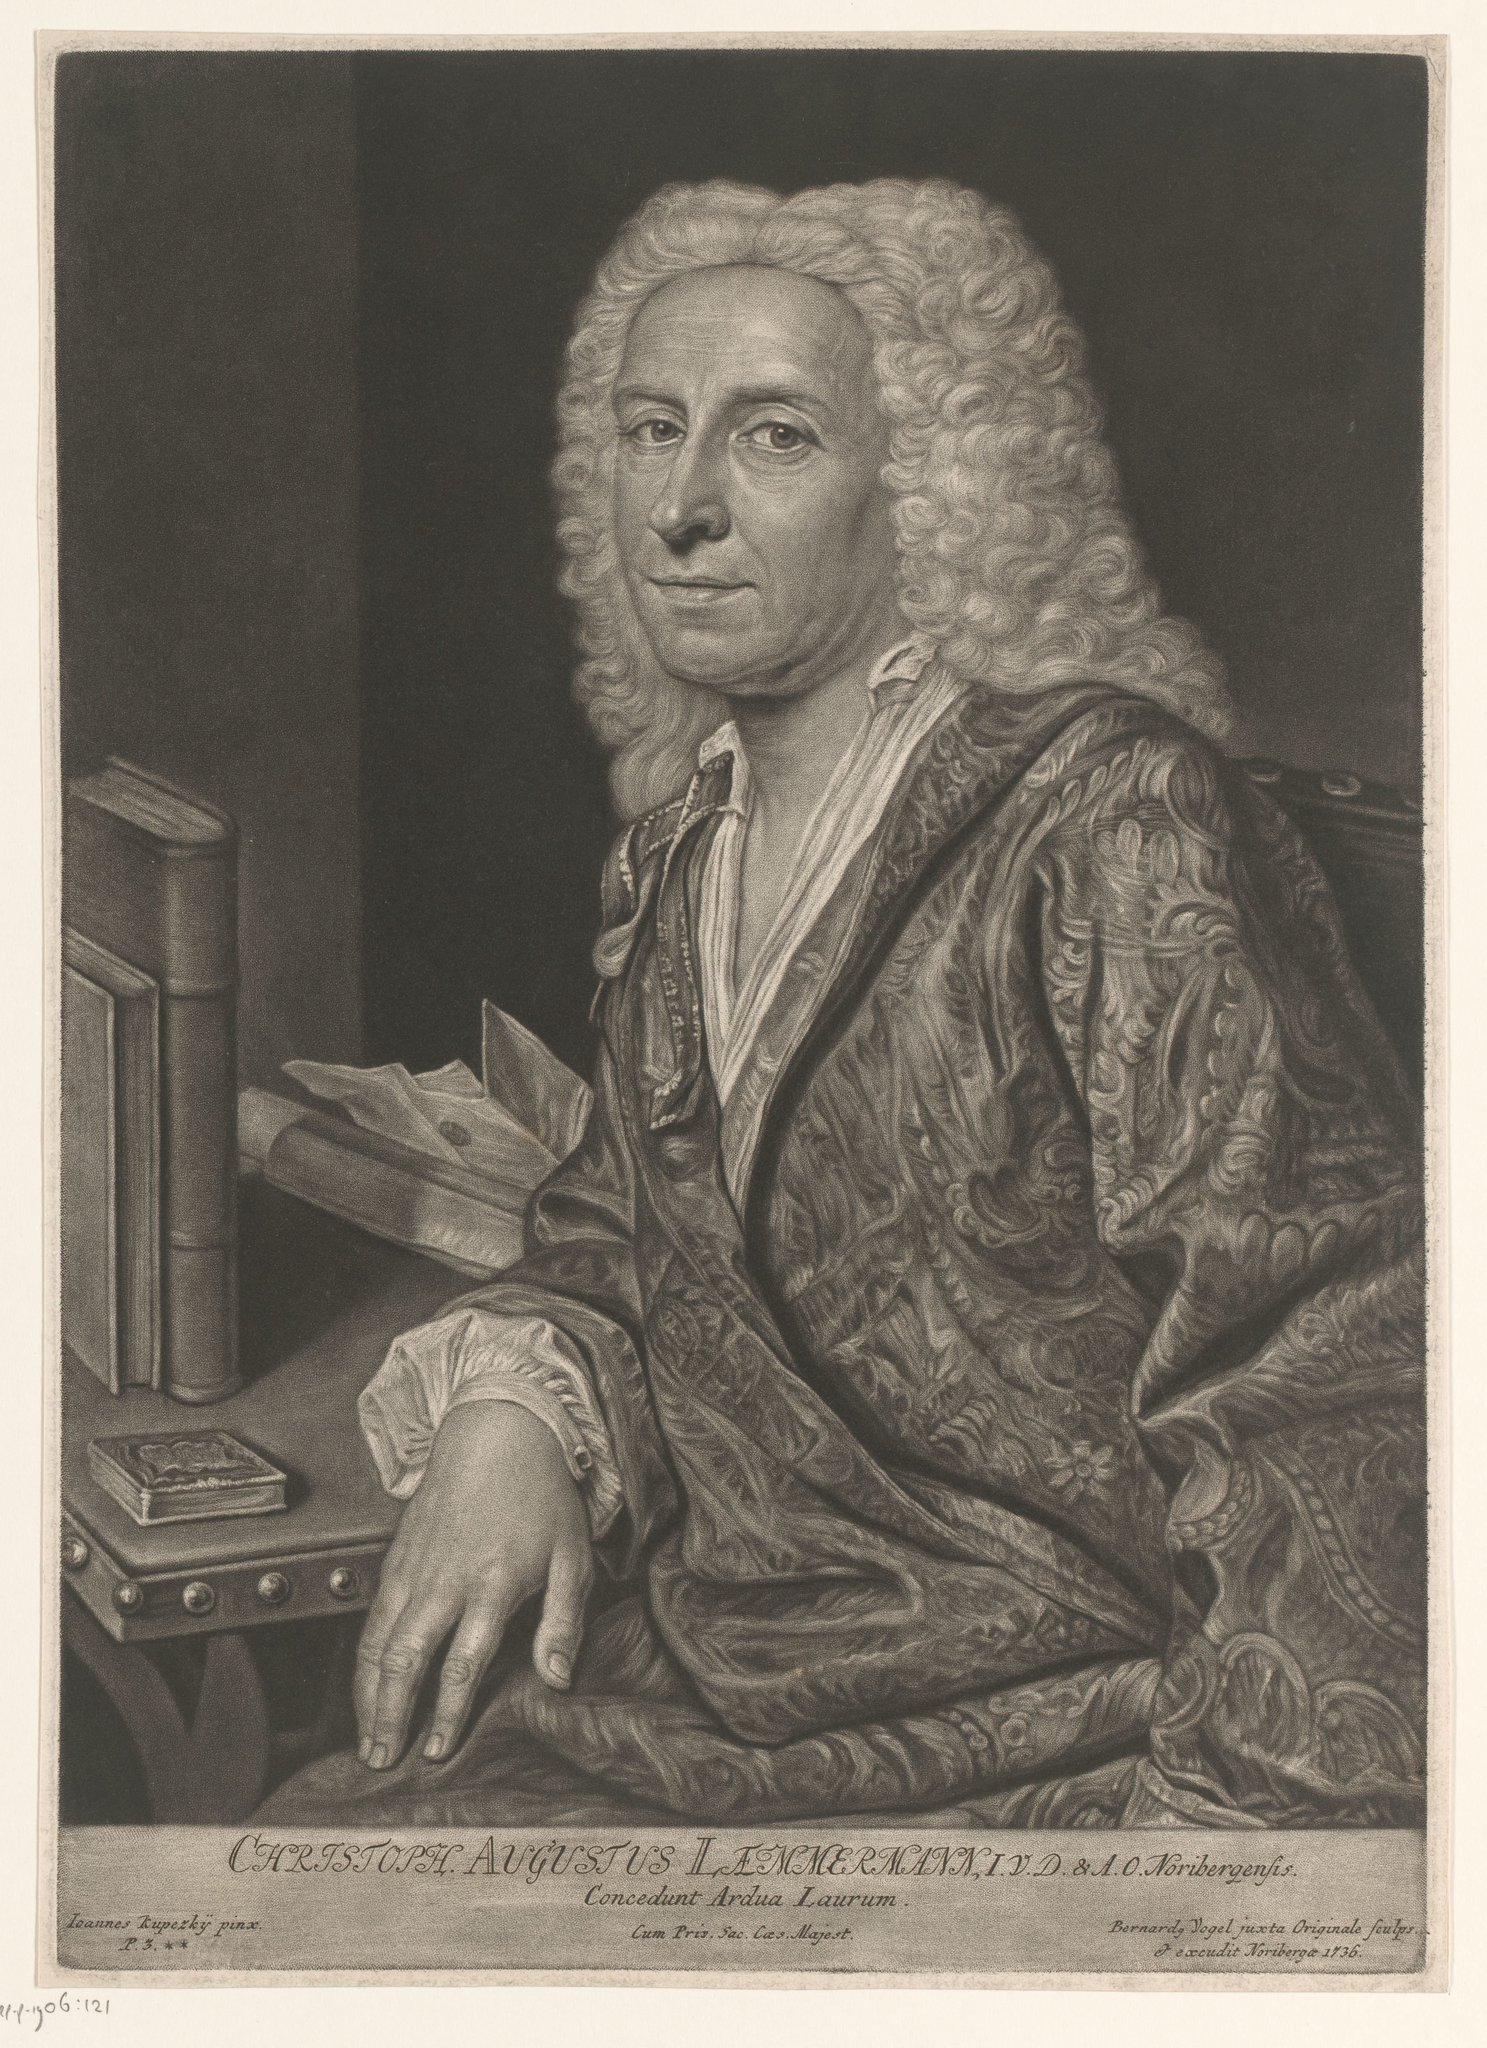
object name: print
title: Portret van Christoph August Lämmermann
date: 1736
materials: paper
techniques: mezzotint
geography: paris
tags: historical persons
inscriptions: collector's mark: Lugt 2228